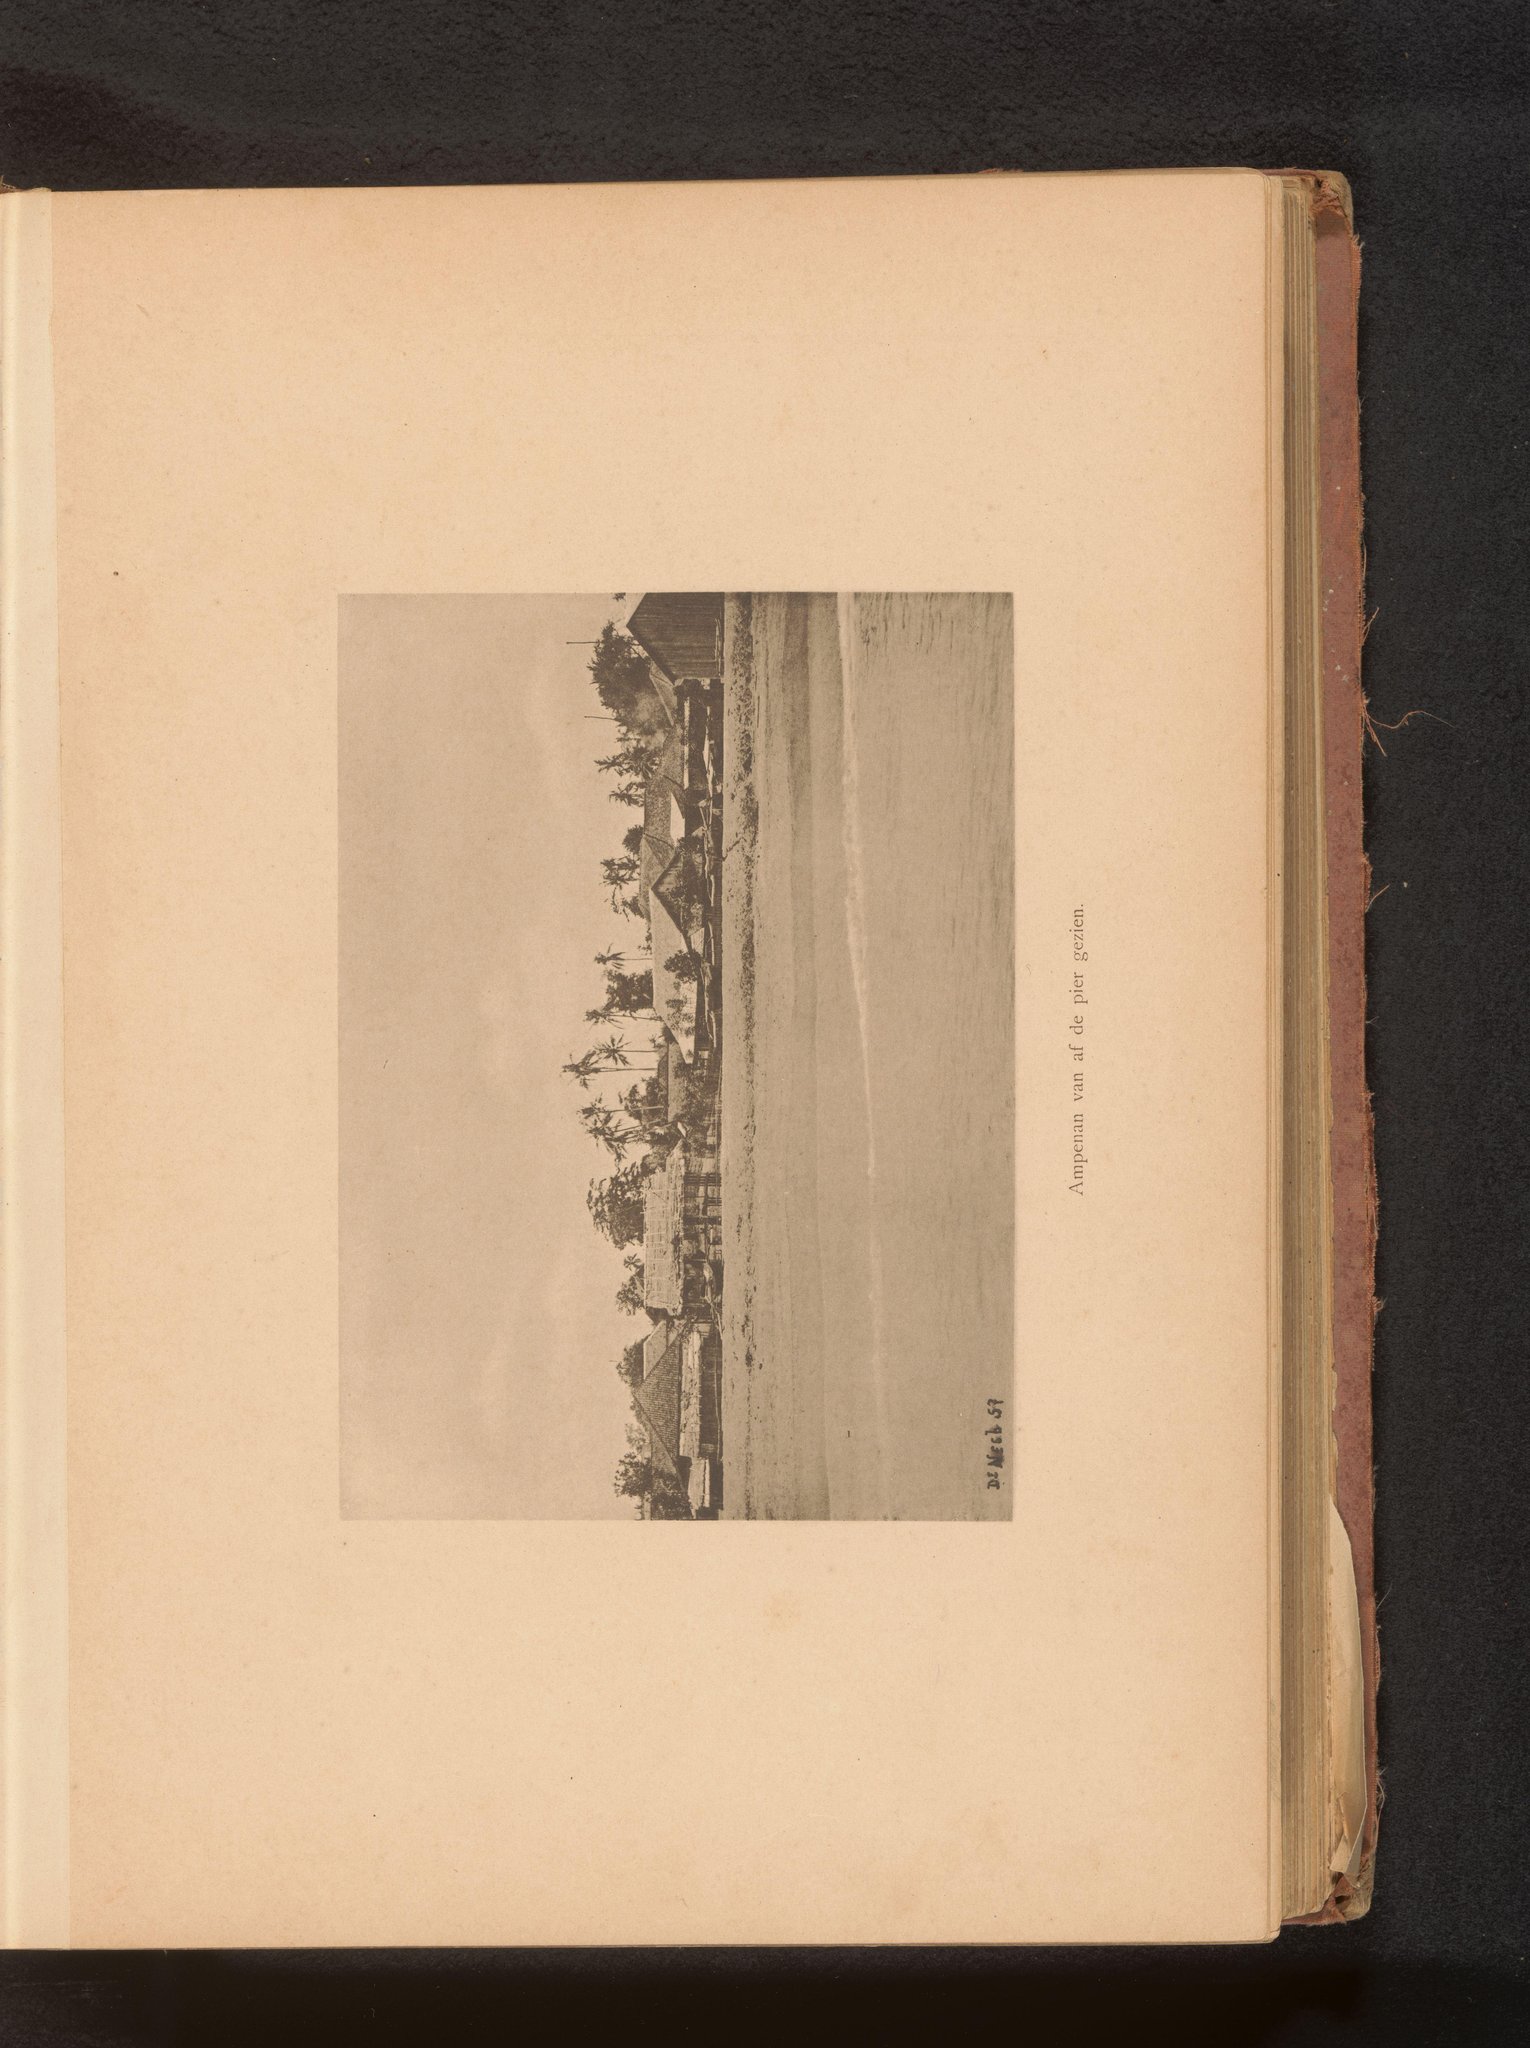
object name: page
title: Ampenan vanaf de pier gezien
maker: christiaan johan neeb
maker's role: arts, fotograaf, officier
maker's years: 1860-1925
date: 1892-1897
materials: paper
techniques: photograph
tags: deep sea, trees: palm-tree, beach